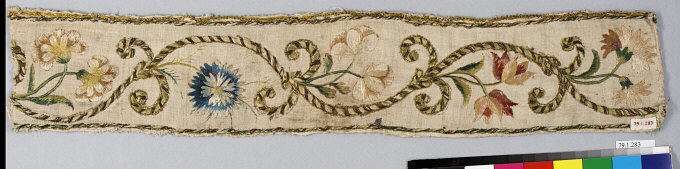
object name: border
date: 1601-1700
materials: linen, silk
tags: flowers